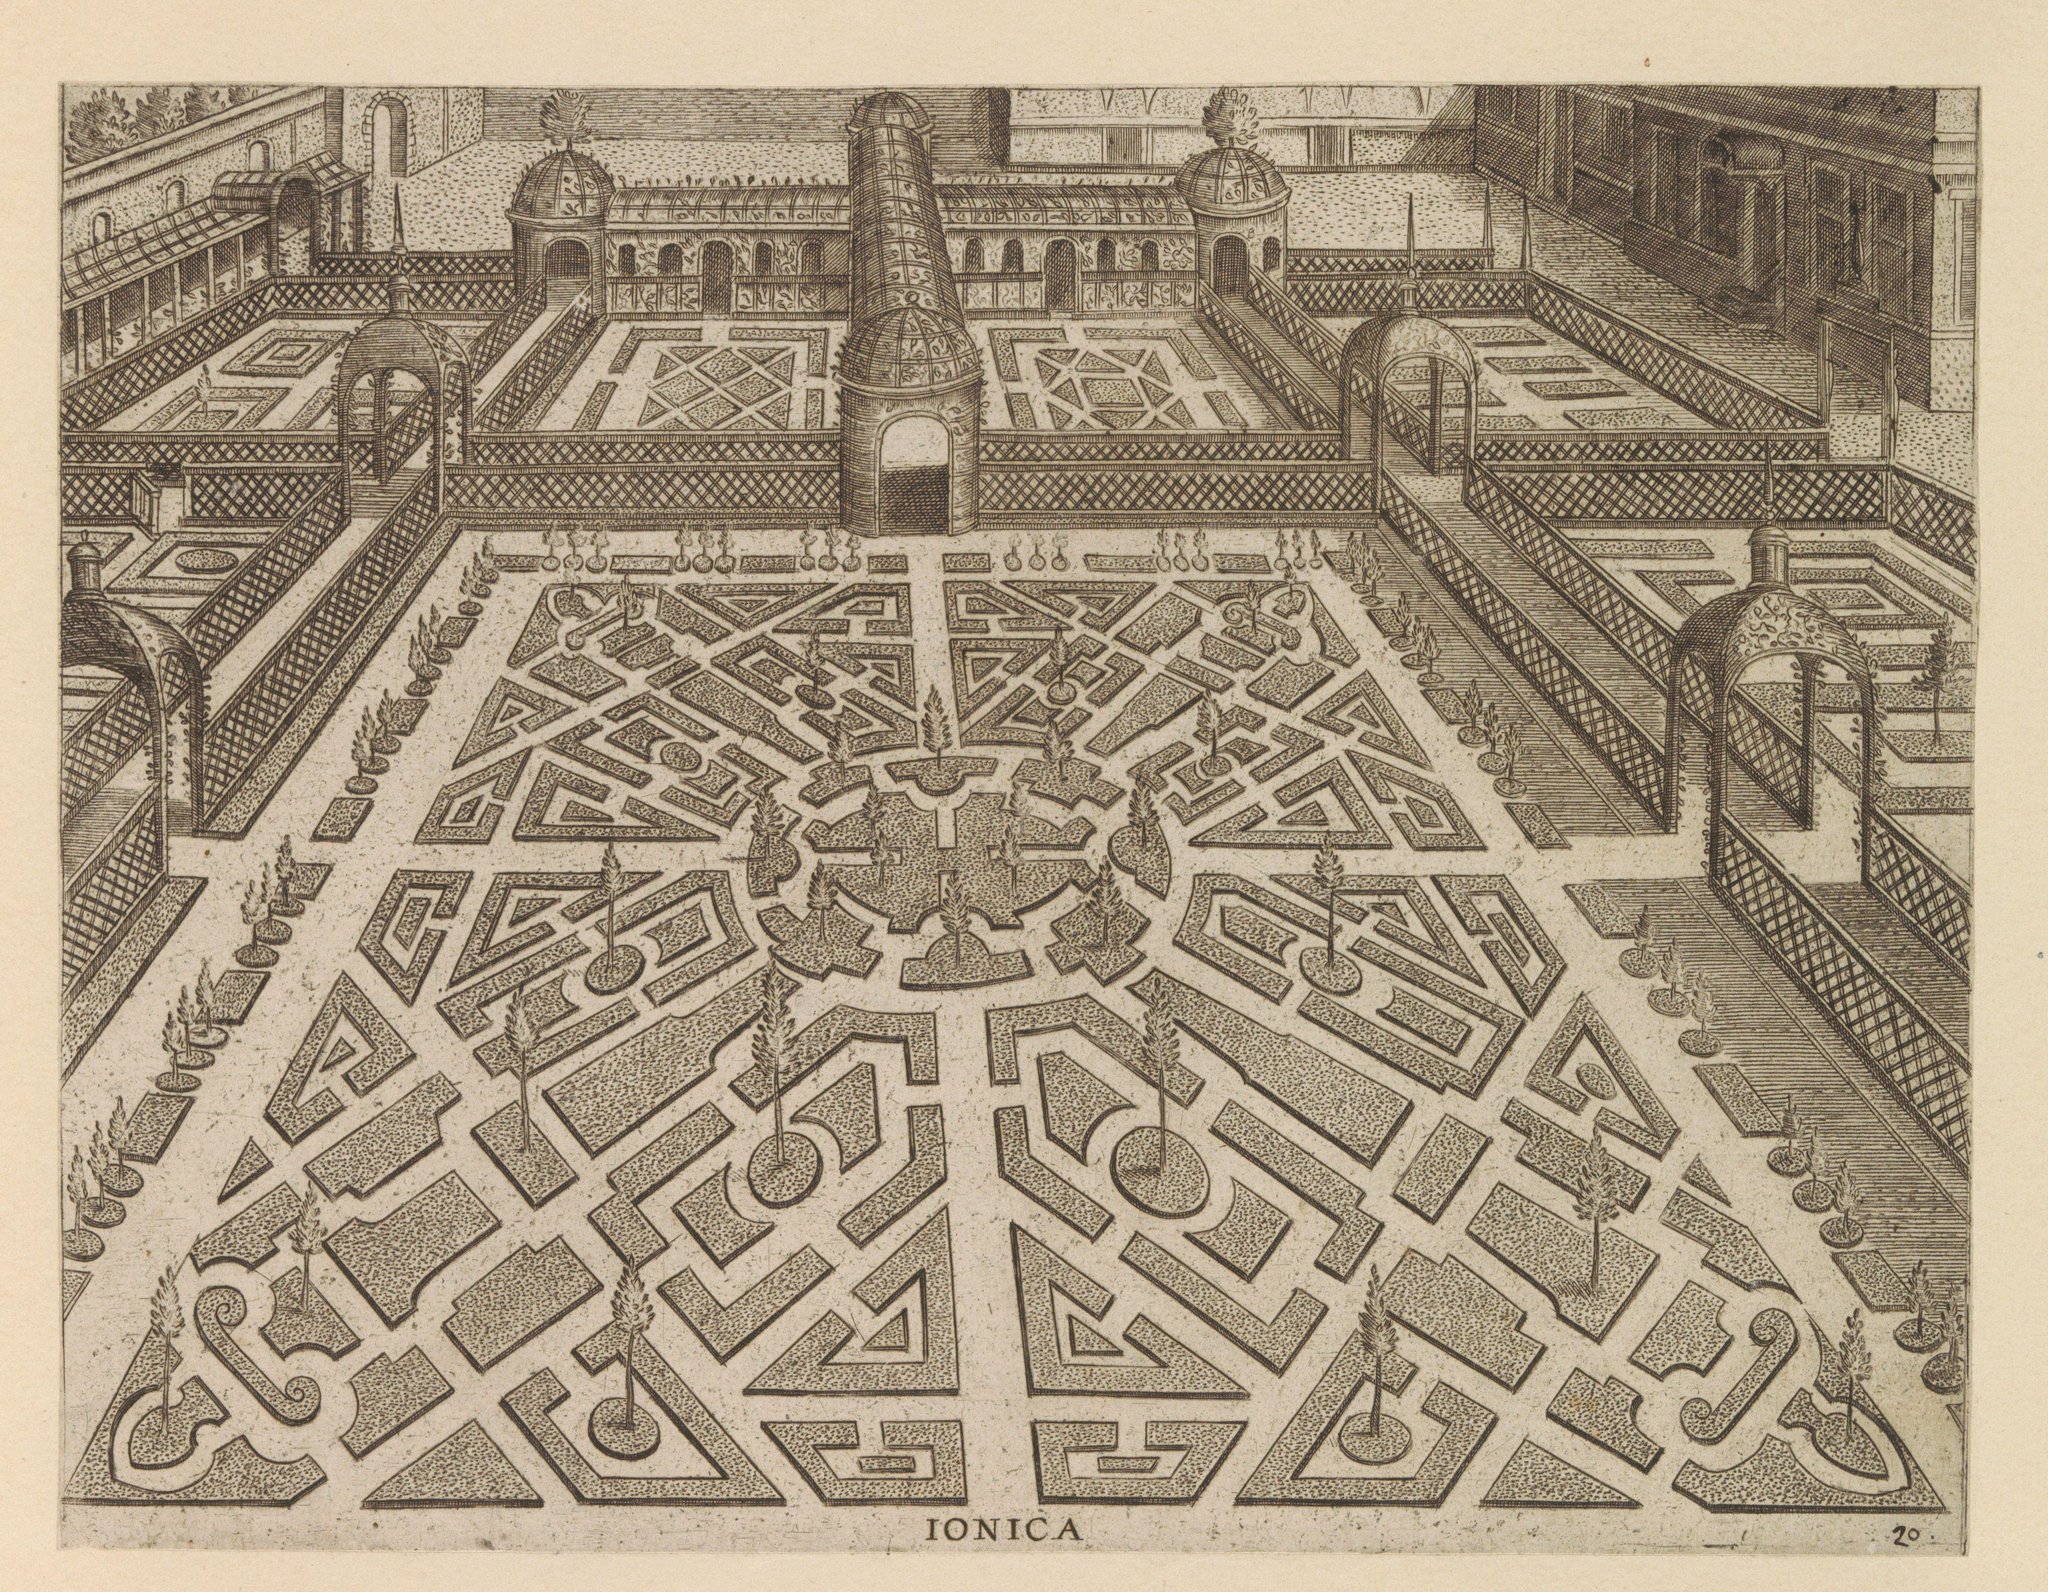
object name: ornament print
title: Hortorum Viridariorumque elegantes et multiplicis formae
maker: Anonymous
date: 1583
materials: paper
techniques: etching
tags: garden, french or architectonic garden; formal garden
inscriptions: inscription: ‘2’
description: Tuin met een parterre, omgeven door hekken en open paviljoens. De tuin is aangelegd volgens de Ionische bouworde. De prent maakt deel uit van een album.